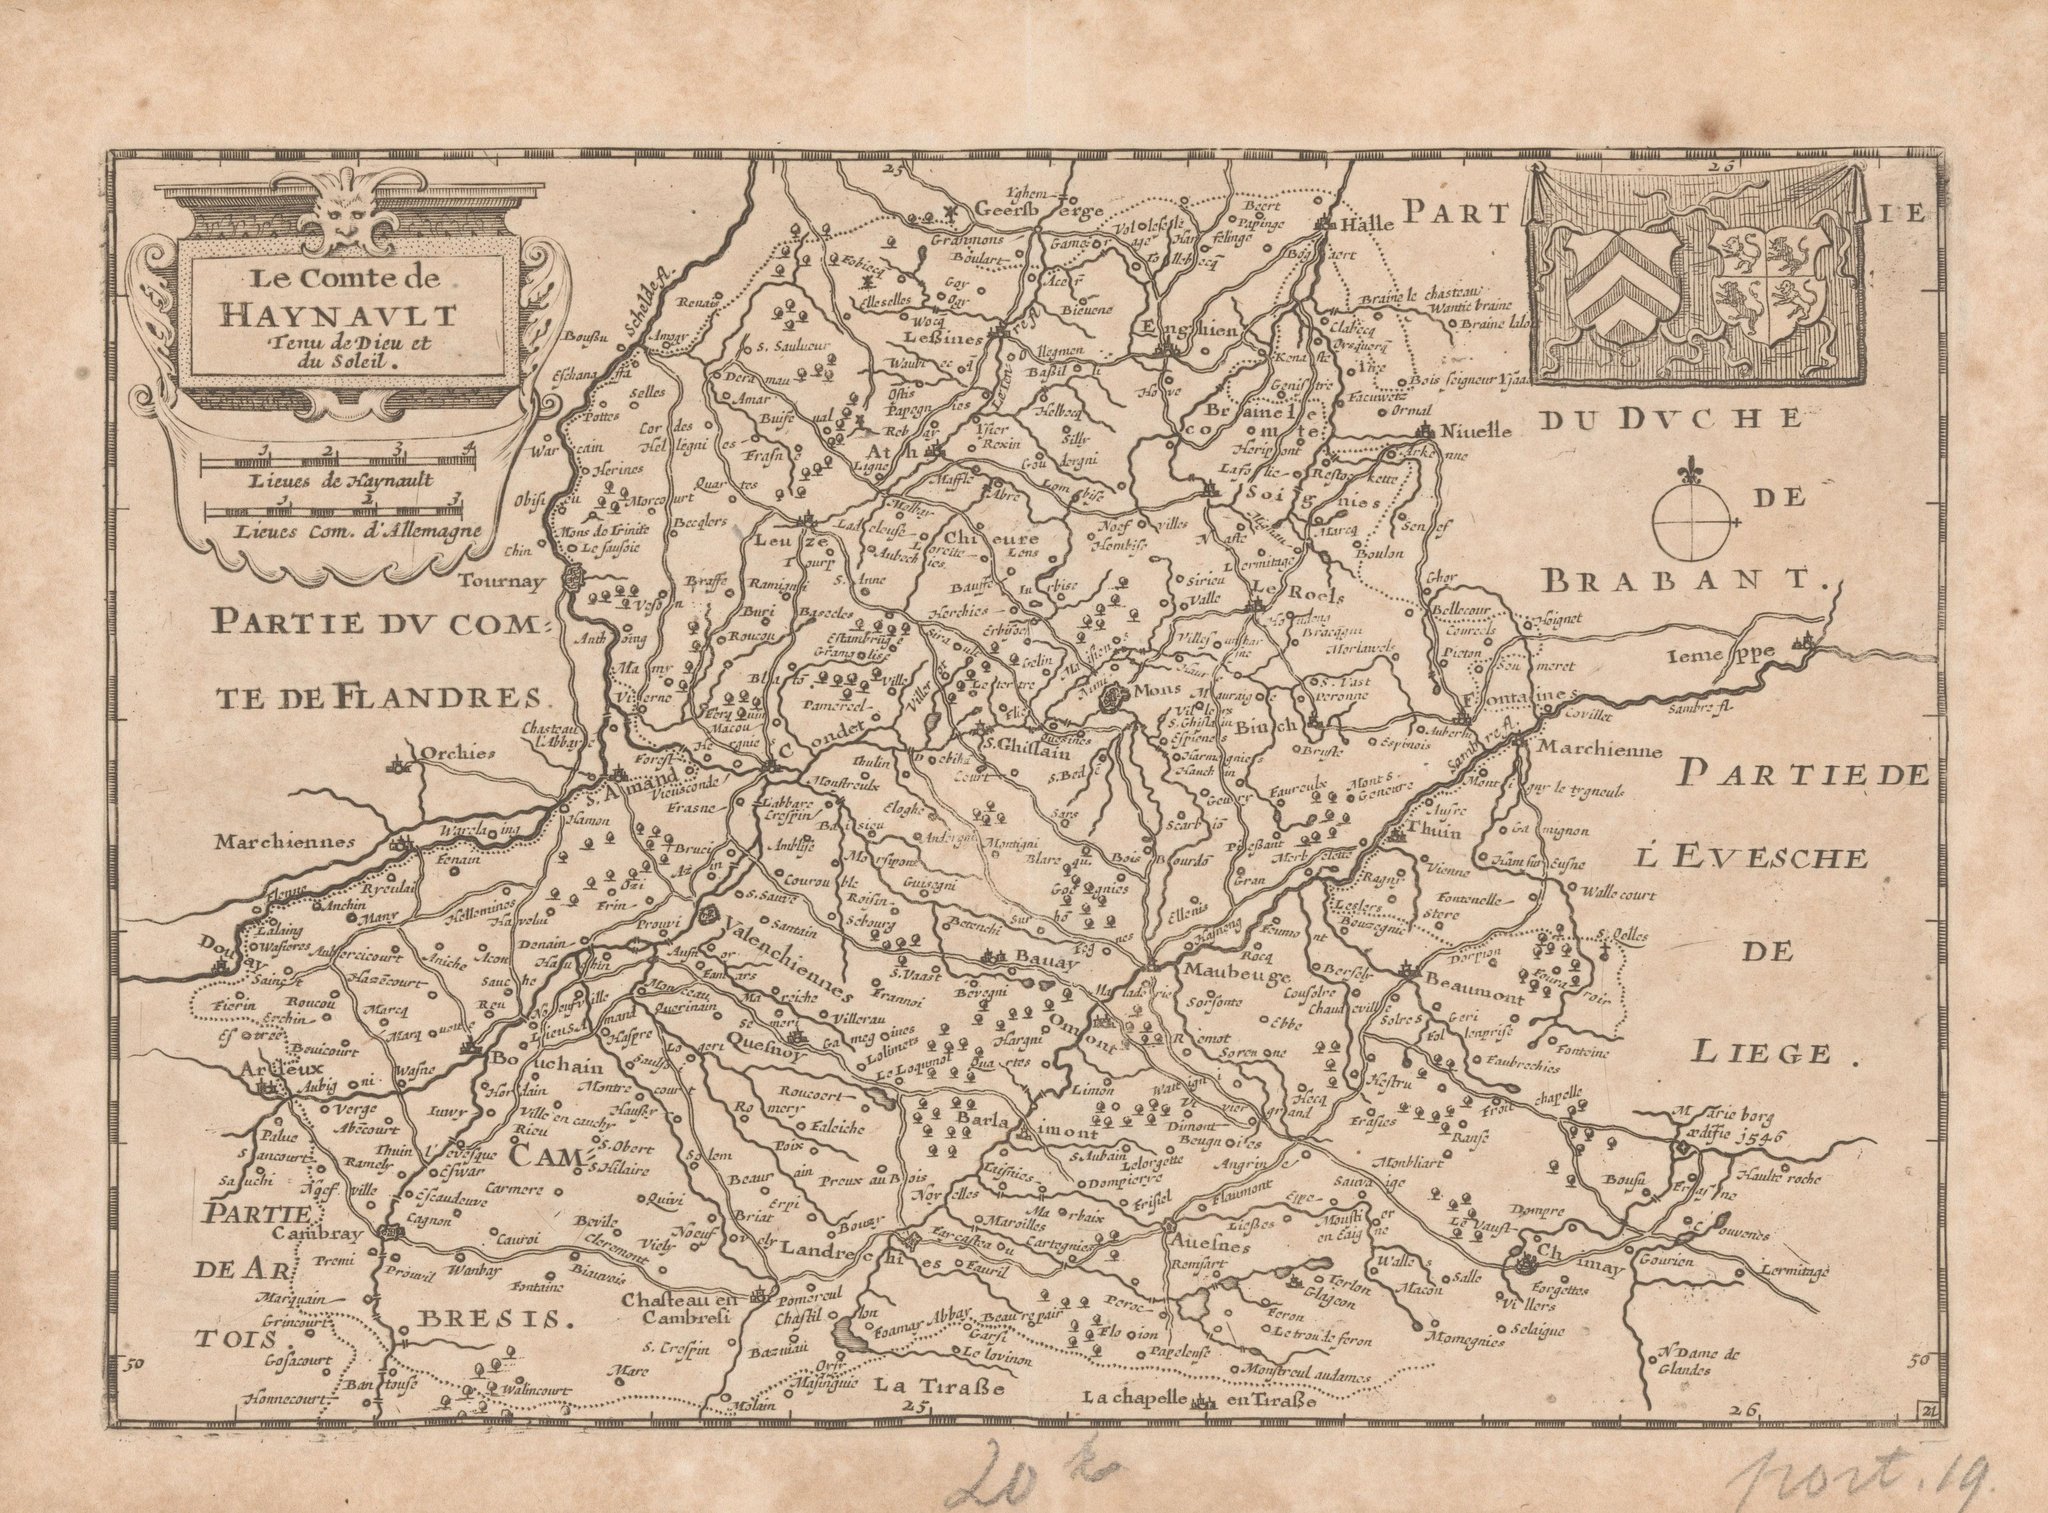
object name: map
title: Le comte de Haynault tenu de Dieu et du soleil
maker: Anonymous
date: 1635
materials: paper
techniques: engraving, etching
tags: maps of separate countries or regions, coat of arms (as symbol of the state, etc.) (+ province; provincial), henegouwen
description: Deze staat van prent ook gebruikt in: De vyerighe colom klaer vertoonende in vyftich onderscheydene curieuse caarten de XVII. Nederlantsche Provincien (…). Amsterdam: Jacob Aertsz Colom (I), s.a. [ca. 1660]. En in latere uitgaven met de platen van deze publicatie, uitgegeven door Pieter van Alphen (1691) en Pieter van der Slaart (1696). Eerdere staat van prent (zonder '21' rechtsonder) ook gebruikt in eerdere drukken van deze publicatie.